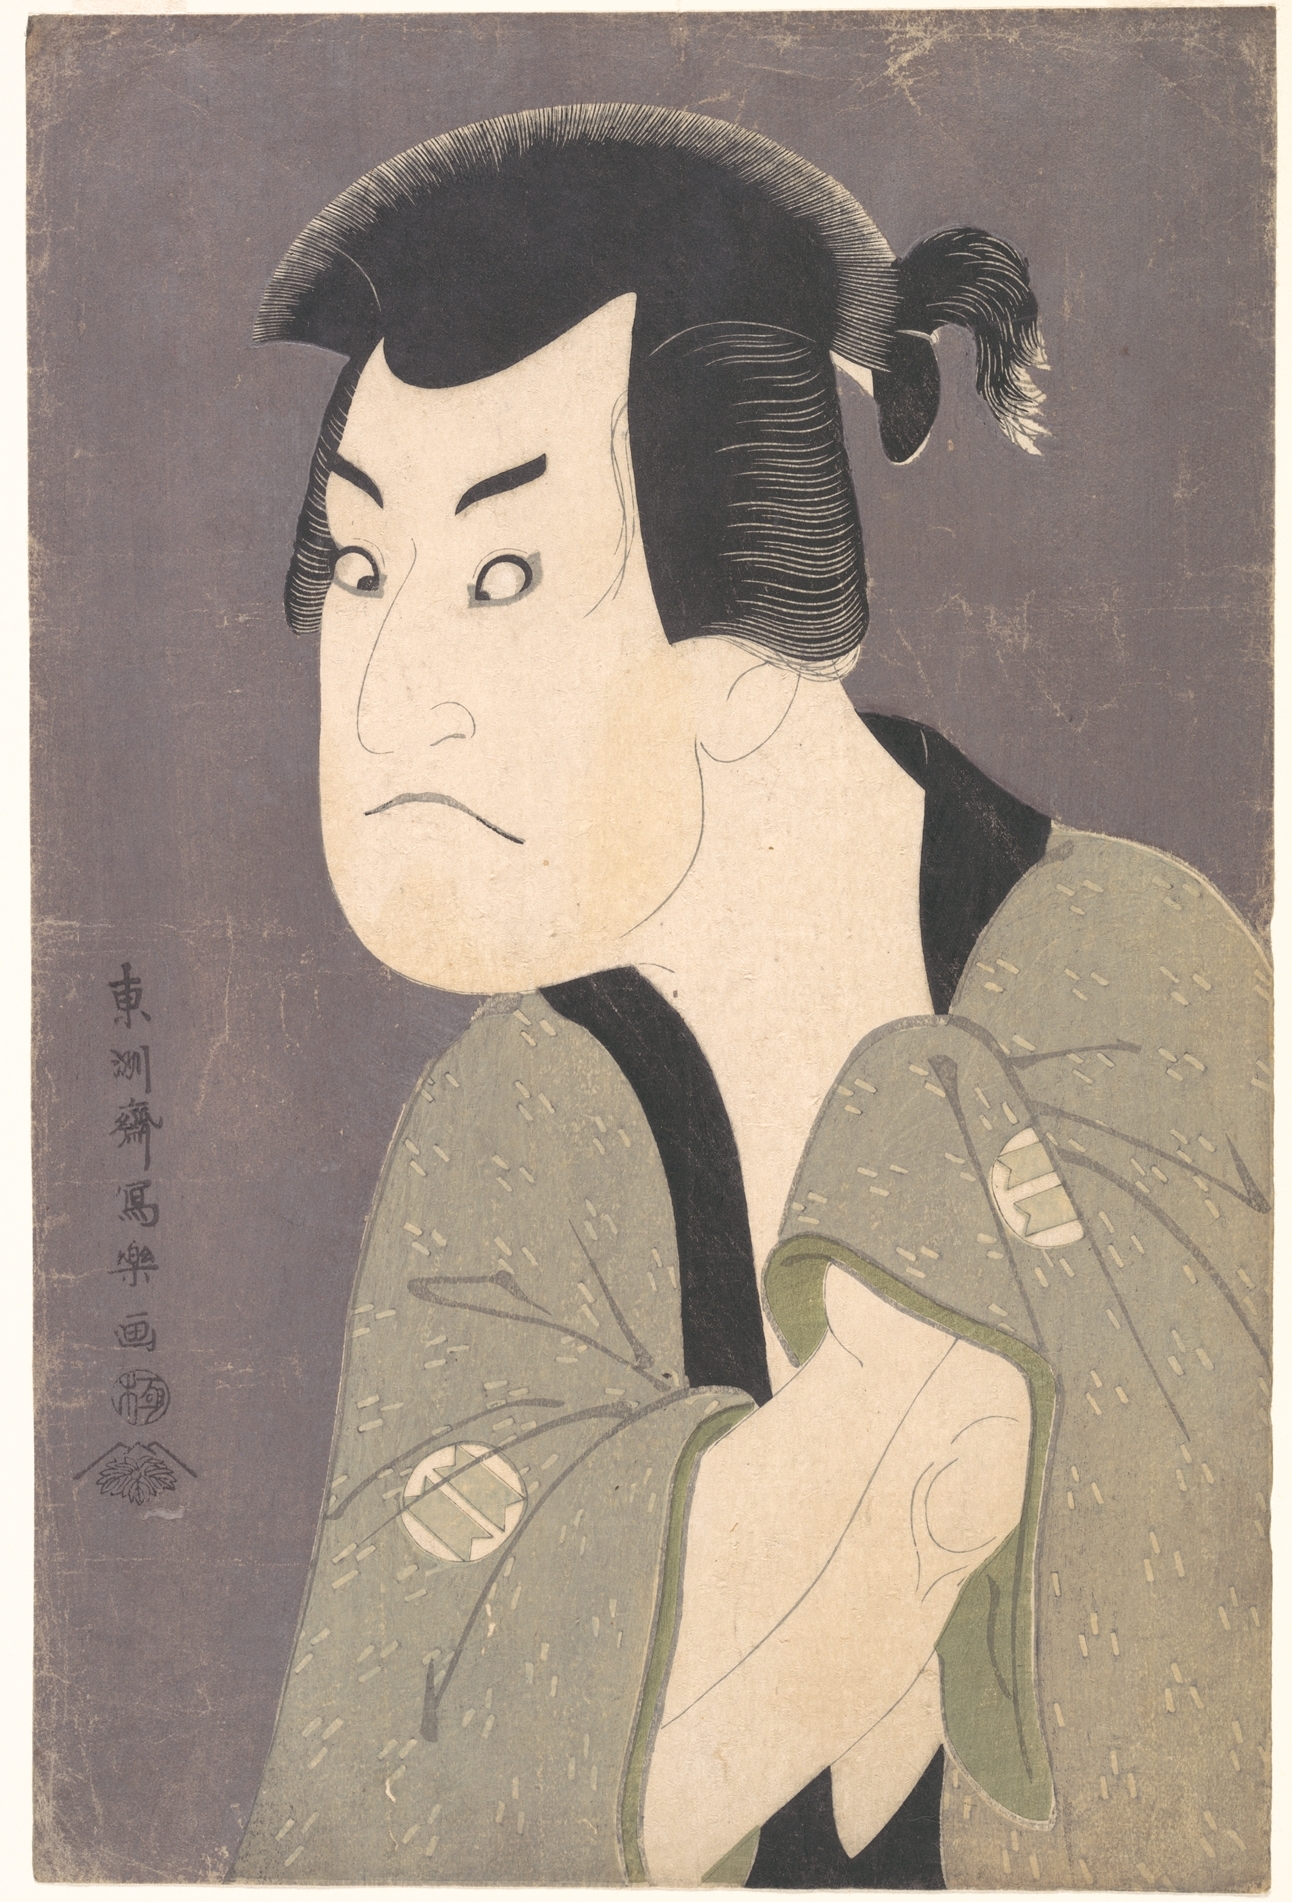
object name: print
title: Sakata Hangorō III as Fujikawa Mizuemon in the Play "Hana Ayame Bunroku Soga"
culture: japanese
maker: tōshūsai sharaku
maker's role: artist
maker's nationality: japanese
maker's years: 1794-1795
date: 1794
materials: ink, mica, paper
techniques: woodblock print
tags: men,actors